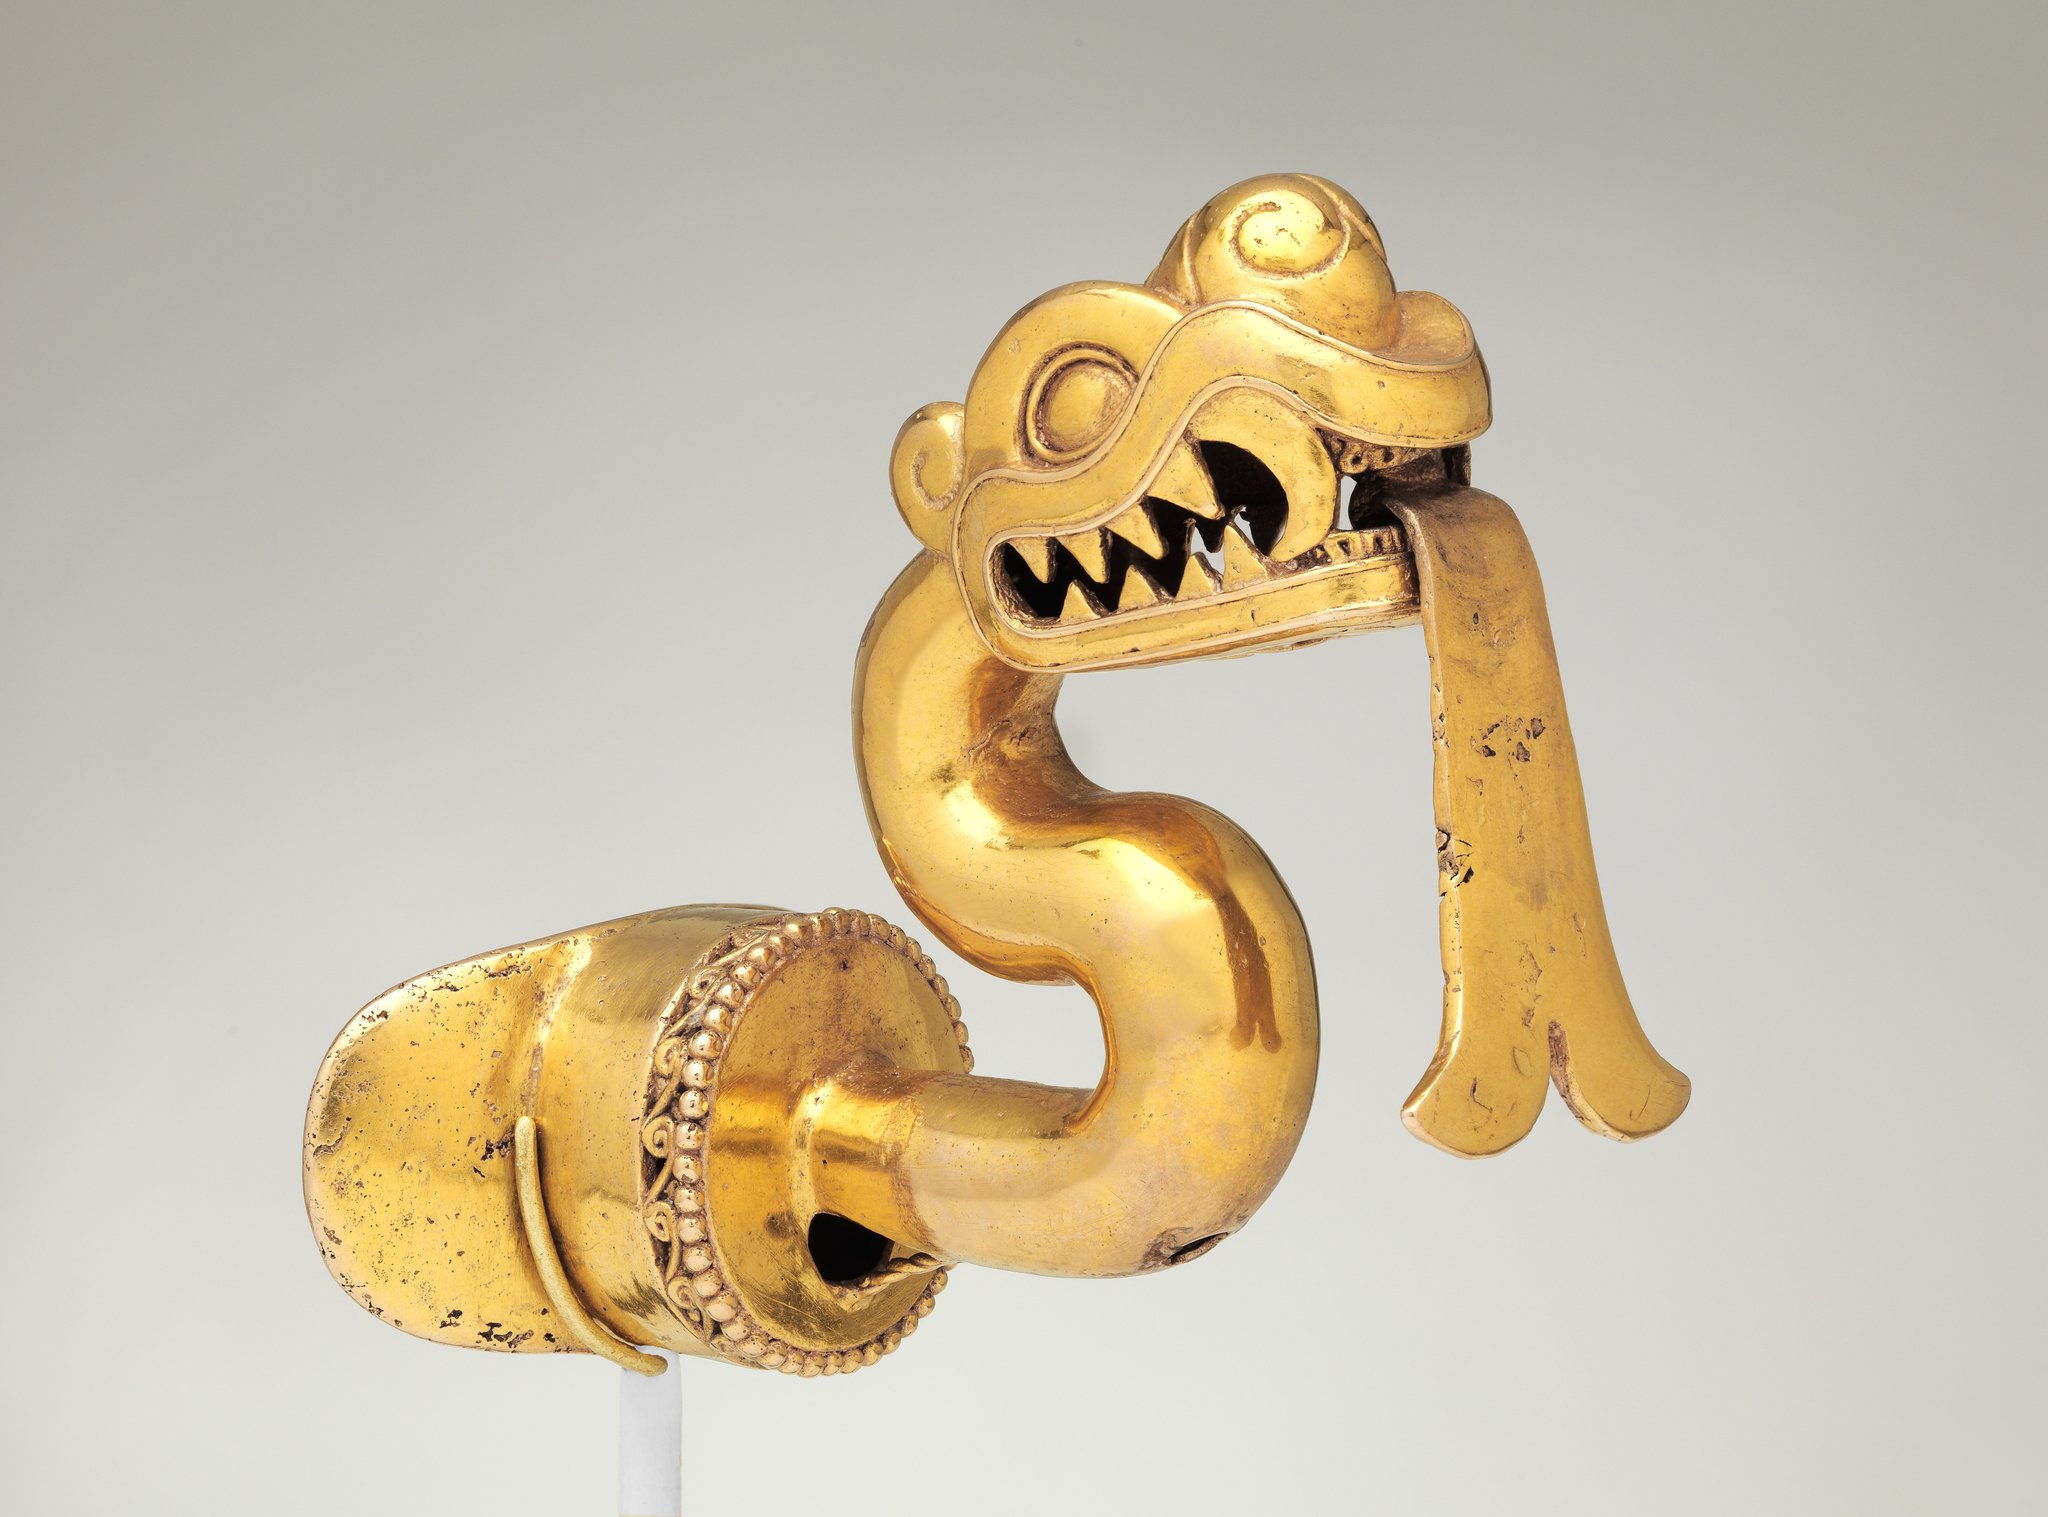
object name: labret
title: Serpent labret with articulated tongue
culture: mexica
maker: mexica artist(s)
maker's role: artist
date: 1325-1521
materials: gold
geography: mexico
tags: serpents